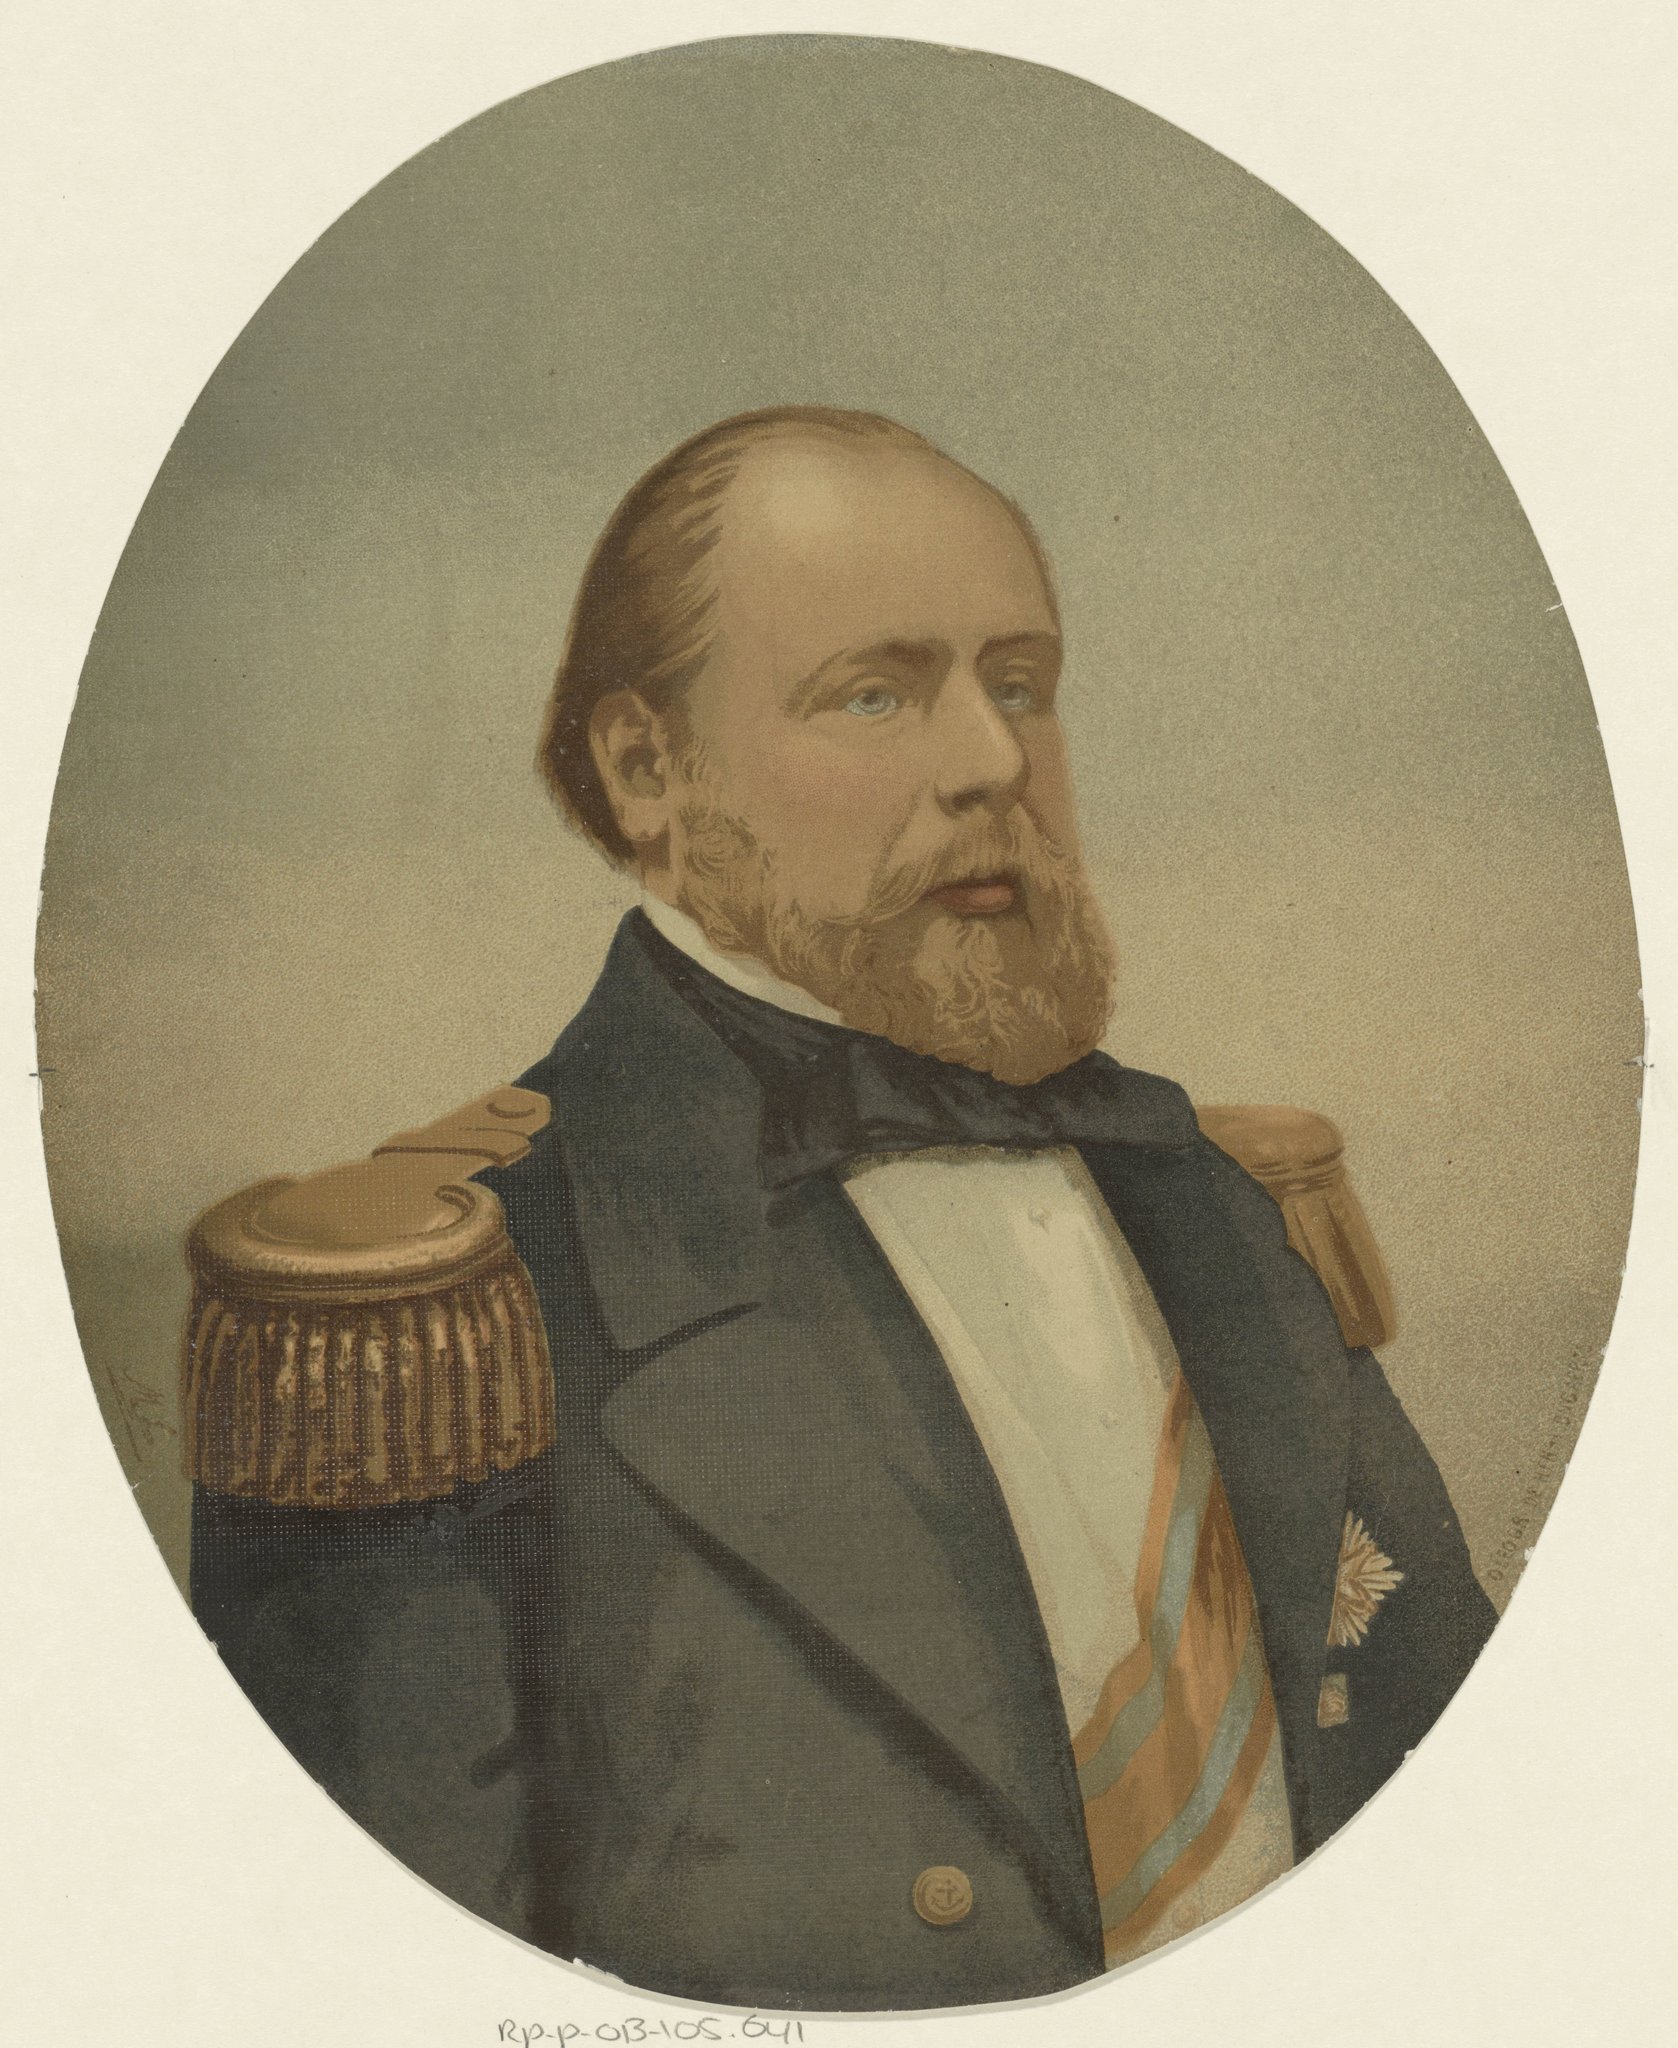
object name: print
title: Portret van Willem III, koning der Nederlanden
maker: henri bogaerts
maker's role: draughtsman, painter, print maker, publisher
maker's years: 1841-1902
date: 1874-1902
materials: paper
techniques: oleograph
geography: netherlands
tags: brussels, willem iii (koning der nederlanden)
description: De hier vermelde titel verwijst naar de hoogst verkregen titel van de geportretteerde, niet per se naar de titel die de geportretteerde op deze voorstelling draagt.